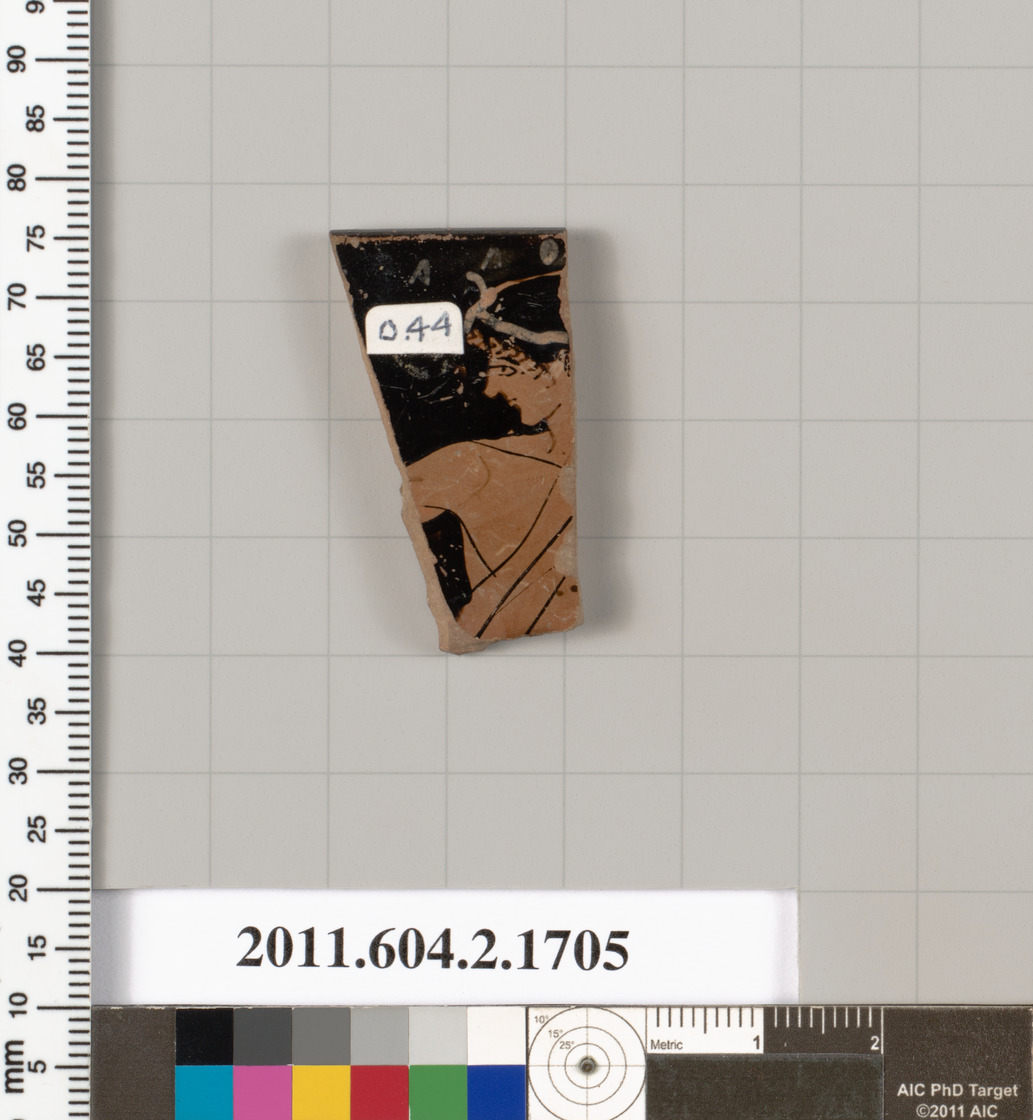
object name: skyphos fragment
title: Terracotta rim fragment of a skyphos (deep drinking cup)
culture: greek, attic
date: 475-451 BCE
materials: terracotta